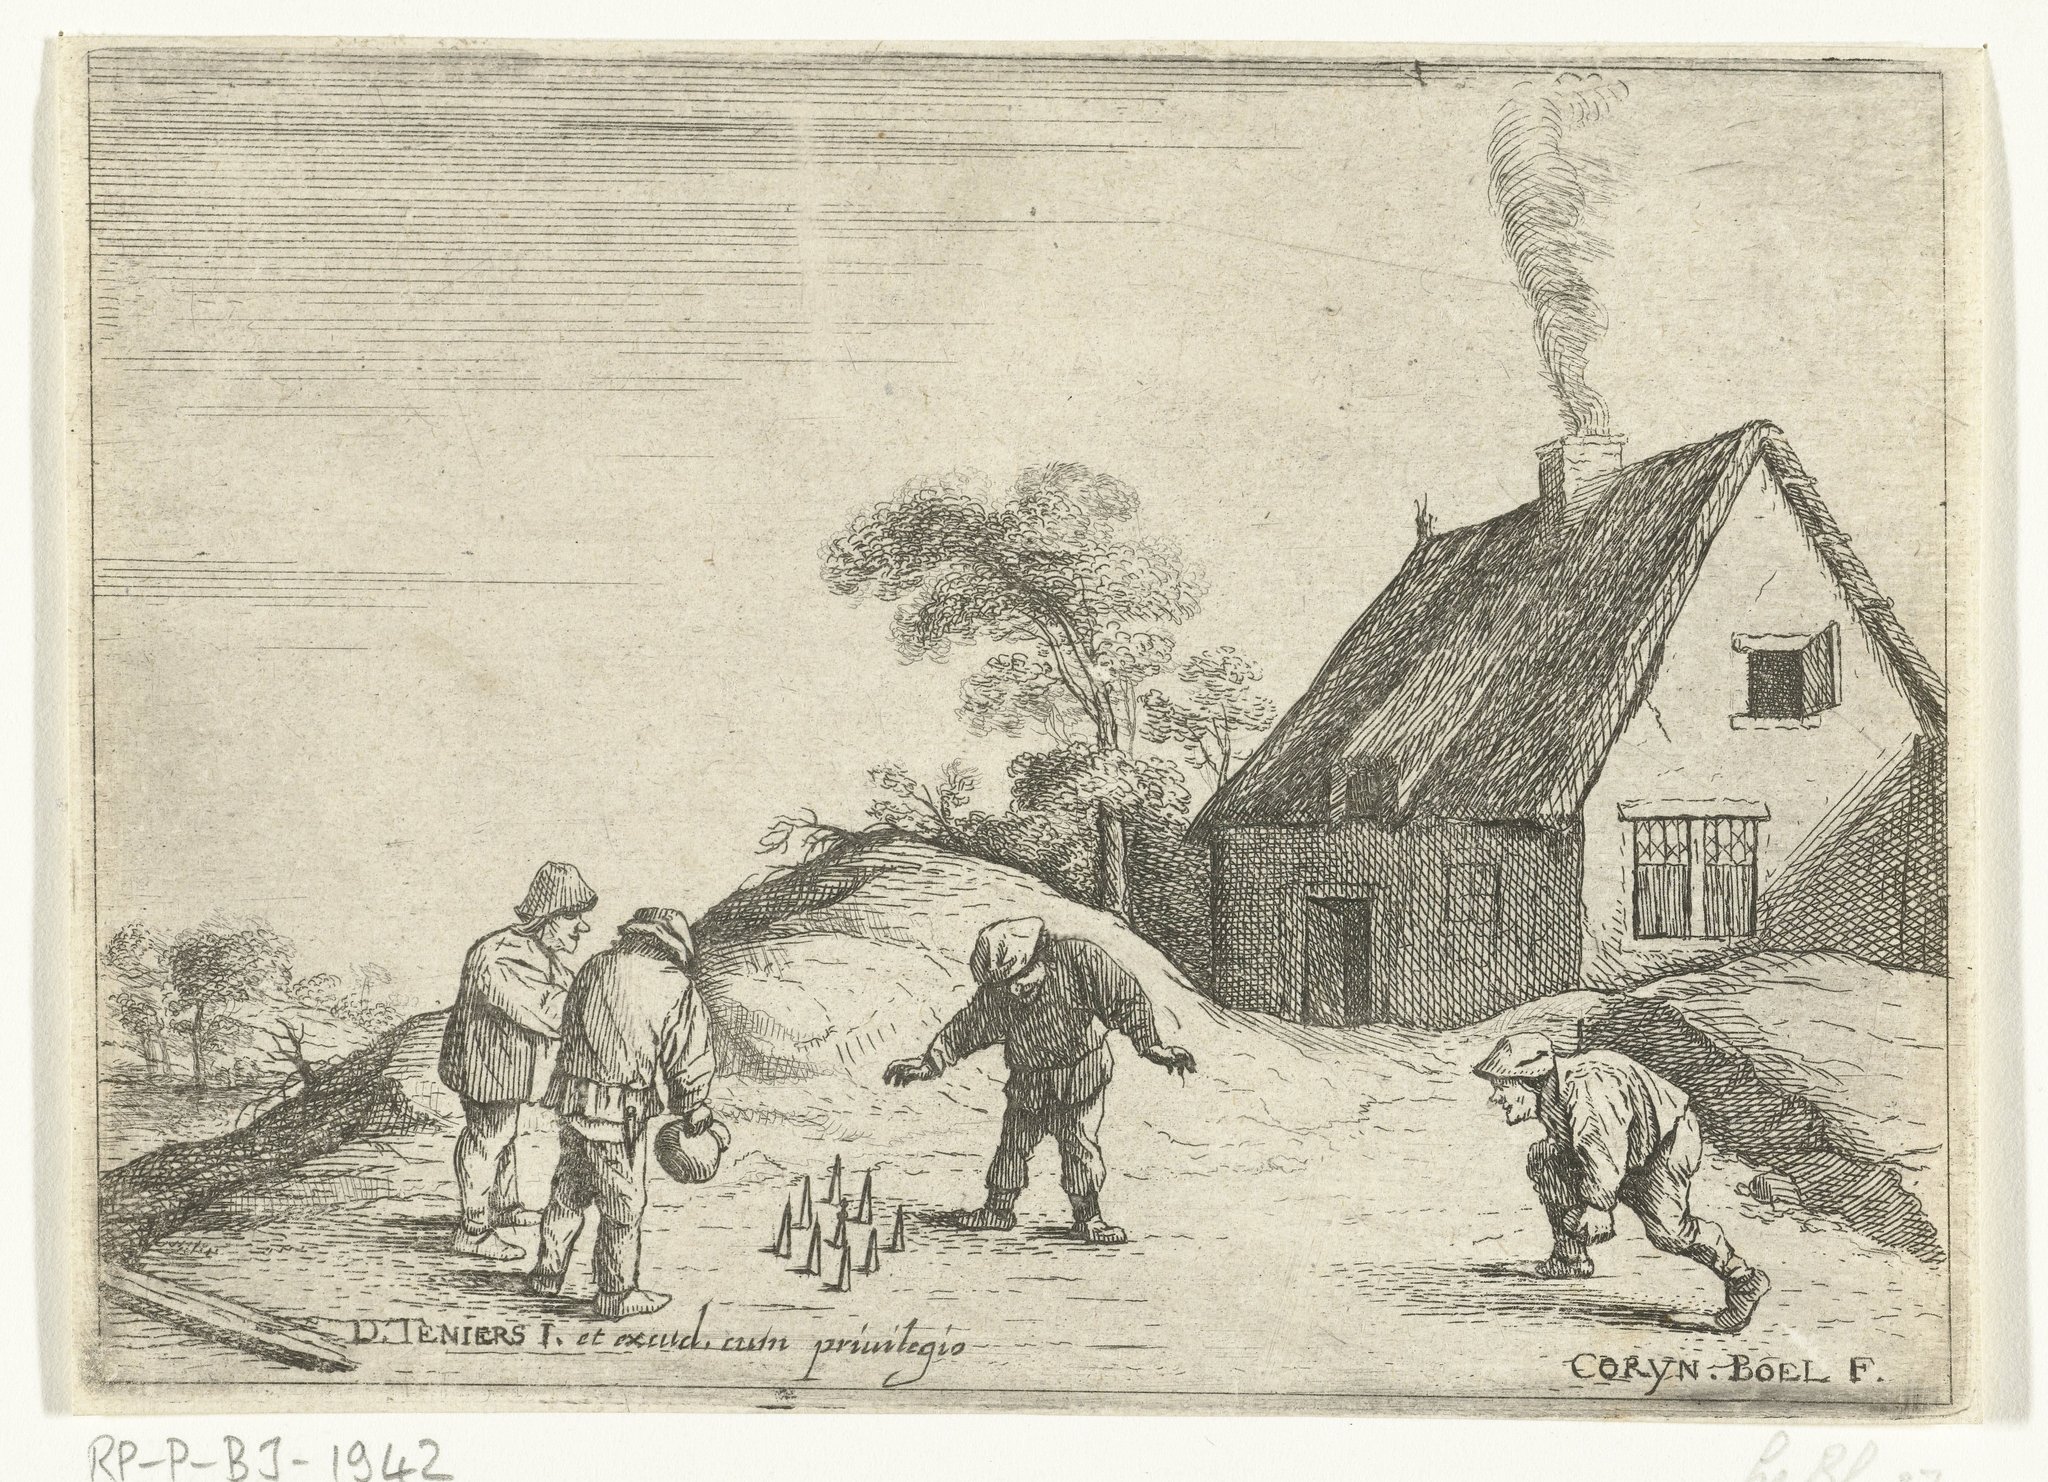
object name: print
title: Boeren bij het kegelen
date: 1635-1668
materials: paper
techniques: etching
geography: southern netherlands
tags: ninepins, skittles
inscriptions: collector's mark: Lugt 240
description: Een groepje van vier boeren is voor een huis aan het kegelen.